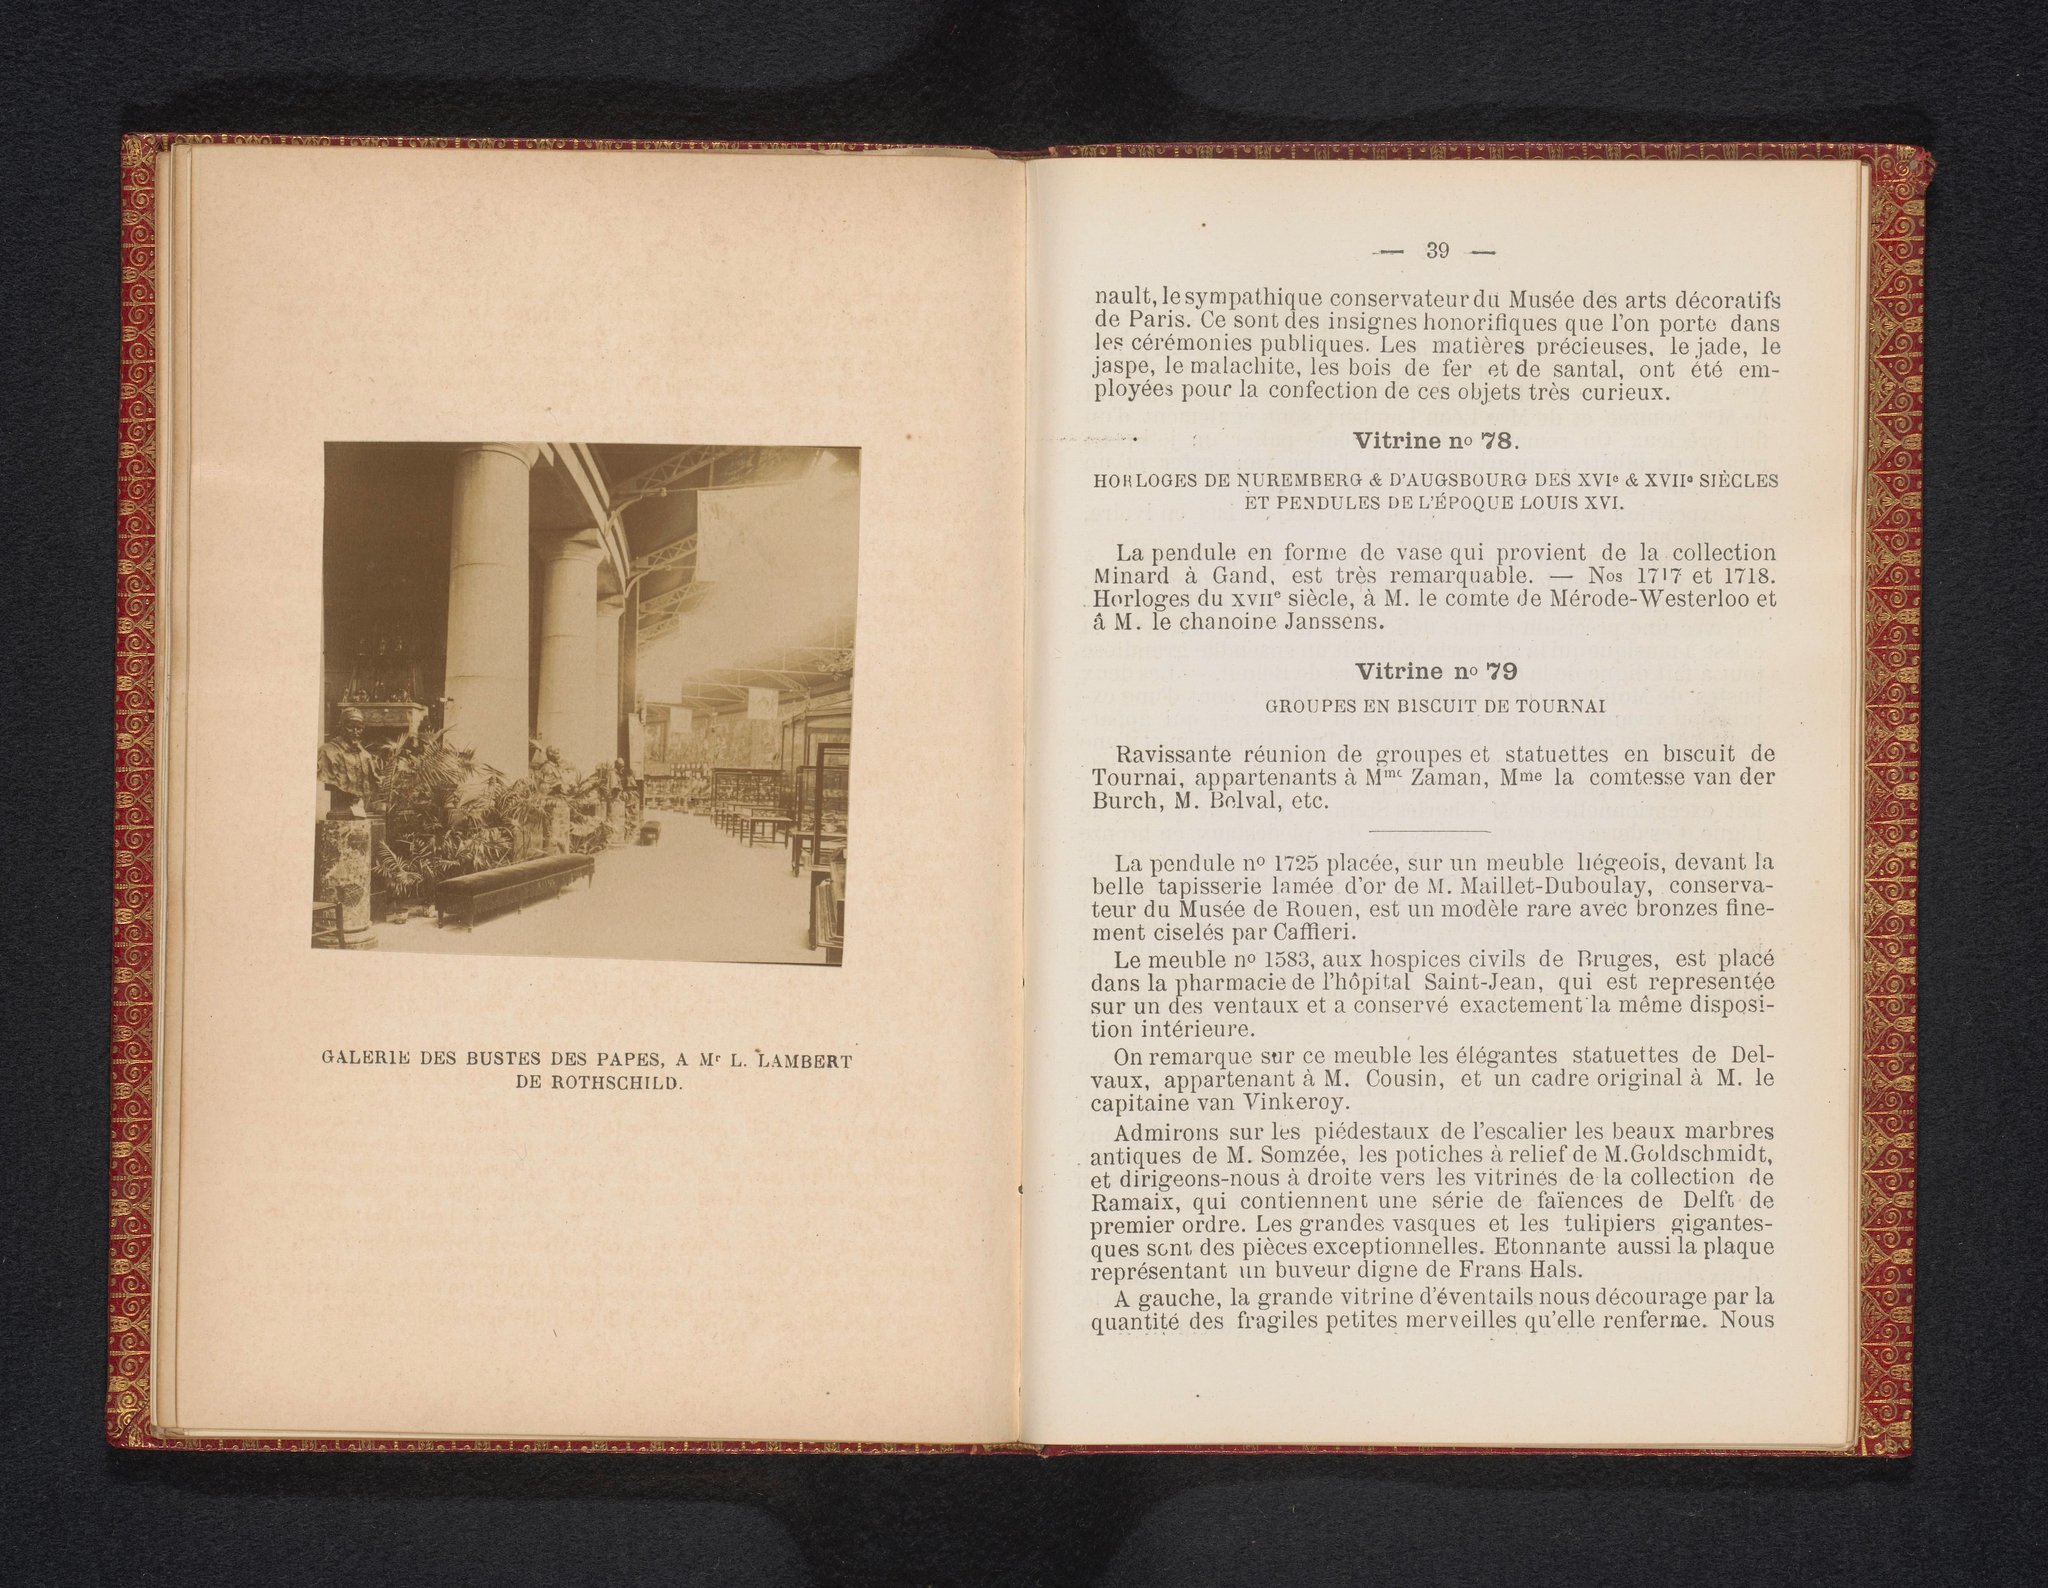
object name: page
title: Galerie des bustes des papes, a Mr. L. Lambert de Rothschild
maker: Anonymous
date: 1888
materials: photographic support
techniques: albumen print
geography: brussels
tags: permanent exhibition, museum, pope, brussels